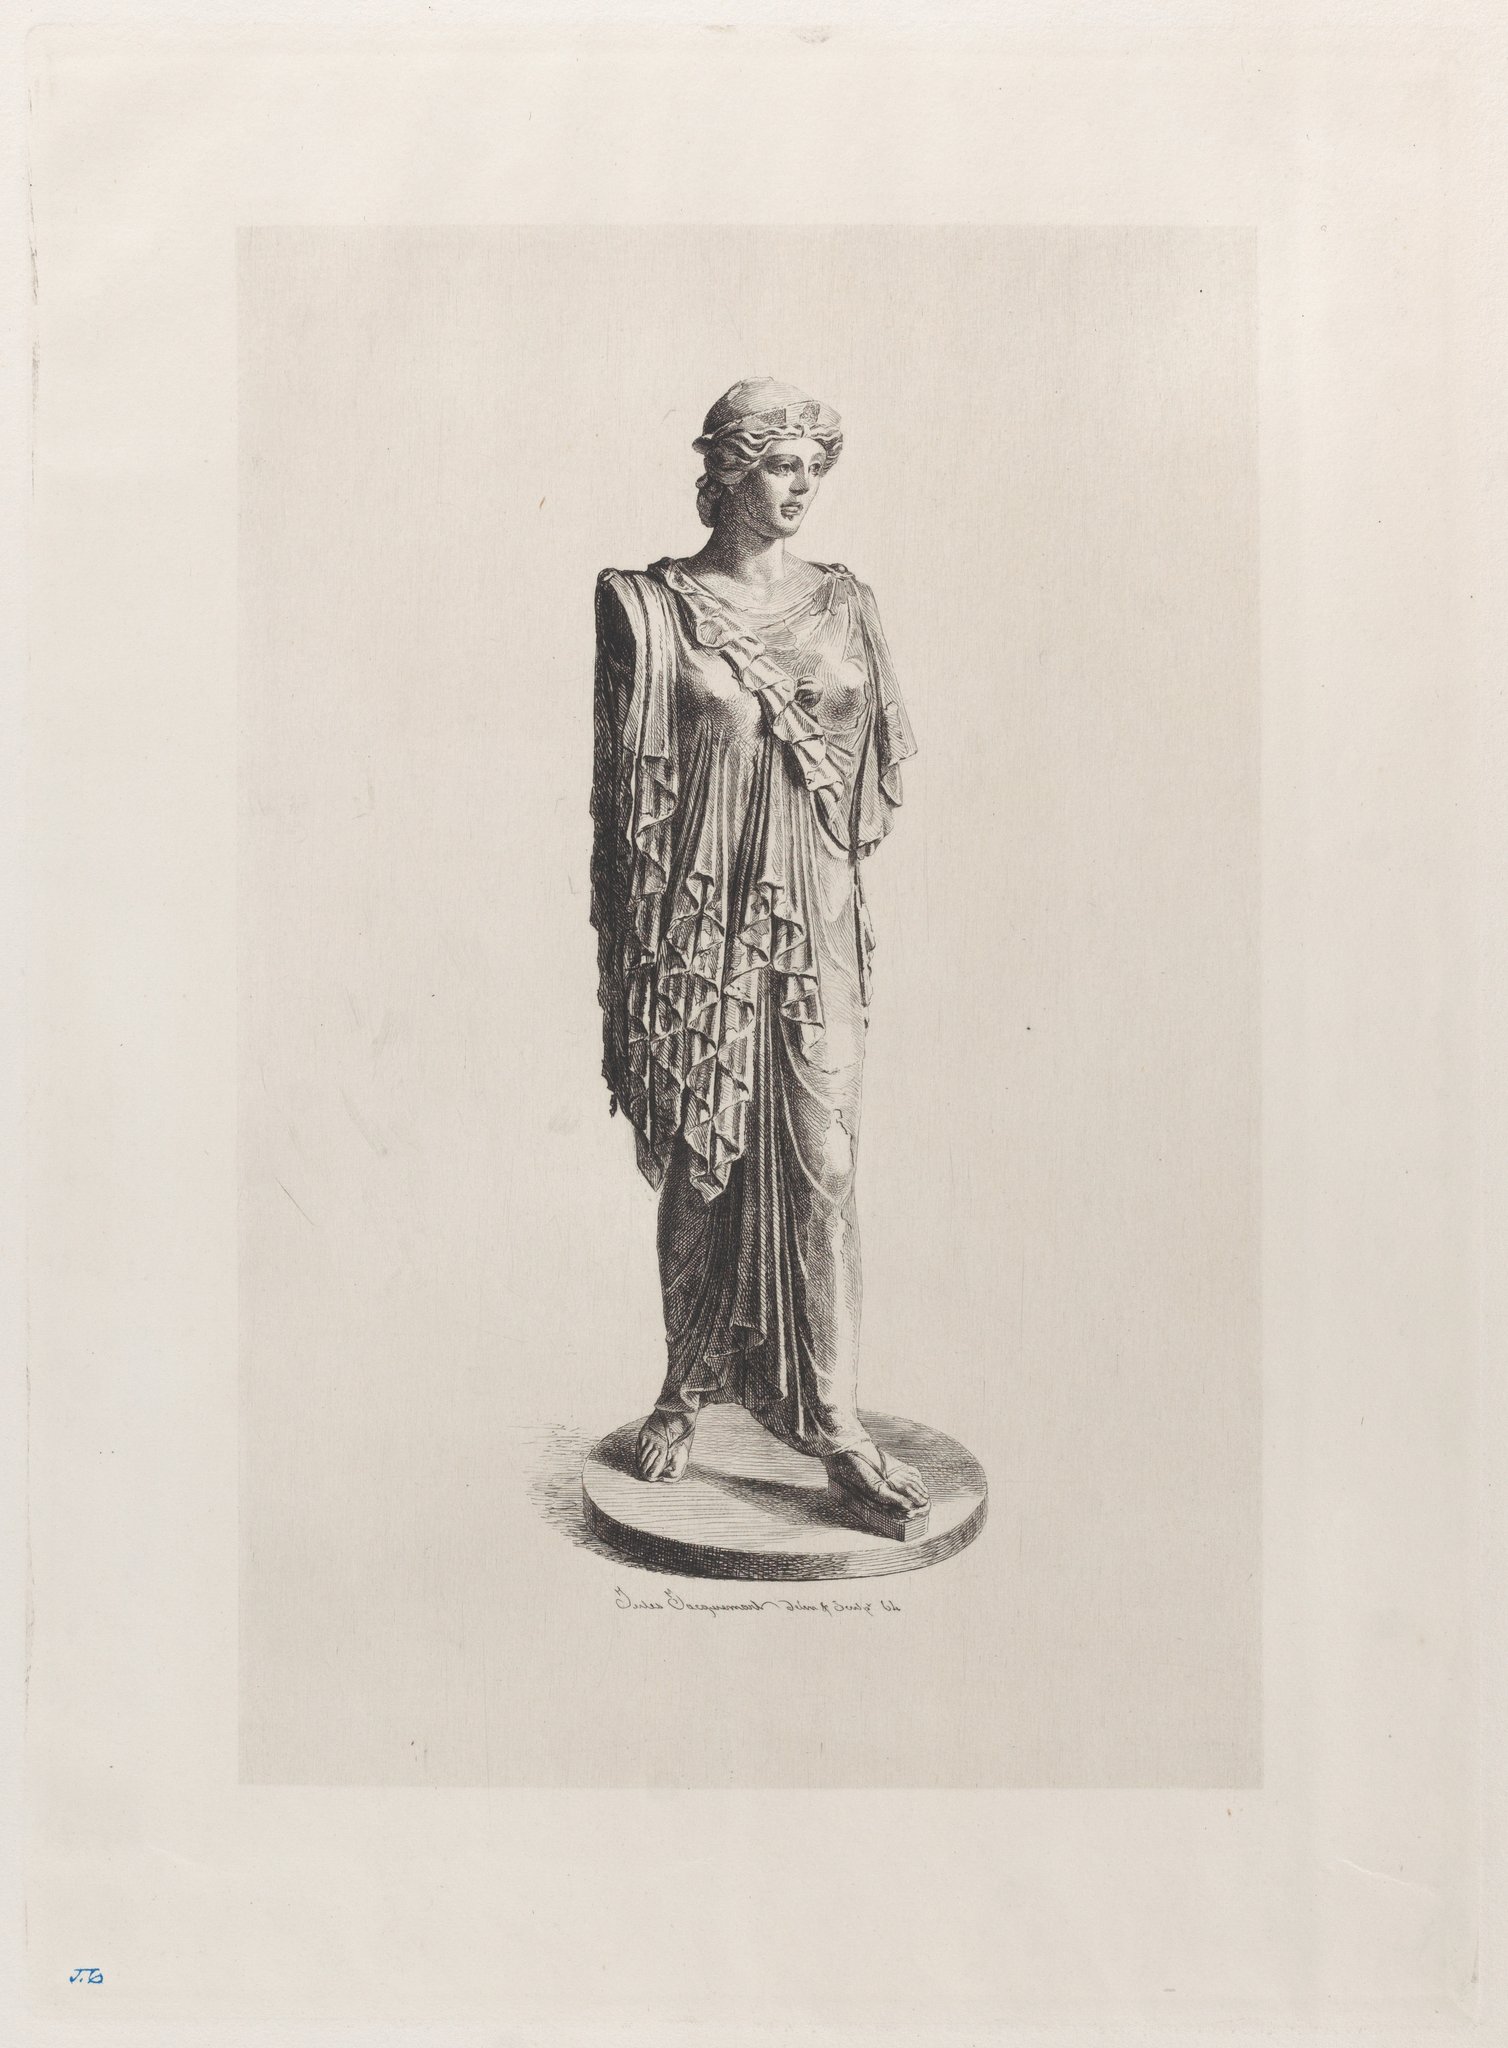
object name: print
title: Minerva of Besançon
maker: jules-ferdinand jacquemart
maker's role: artist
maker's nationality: french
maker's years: 1837-1880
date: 1864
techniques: etching